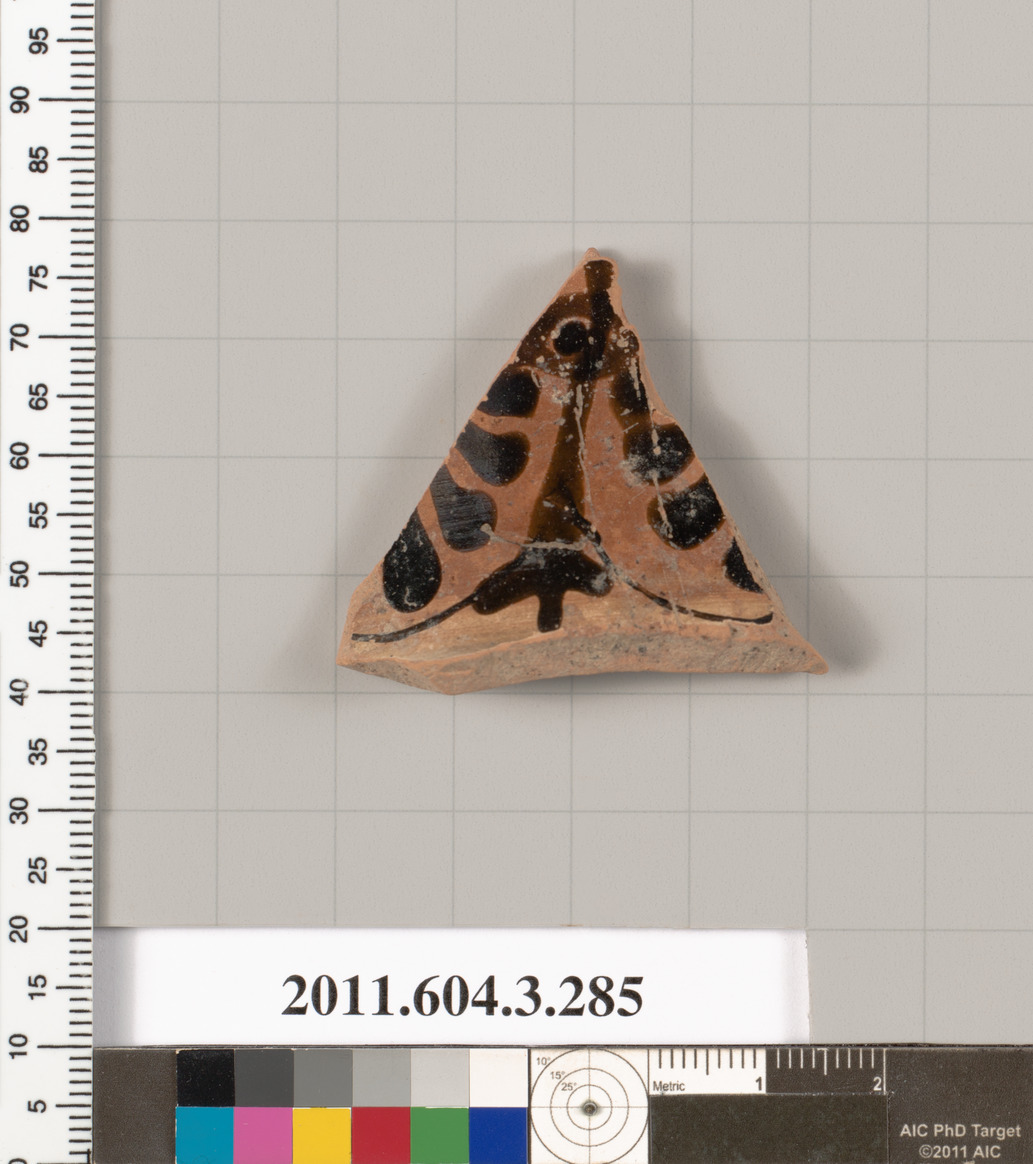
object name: neck amphora fragment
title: Terracotta fragment of a neck-amphora (jar)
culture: greek, attic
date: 520-510 BCE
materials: terracotta